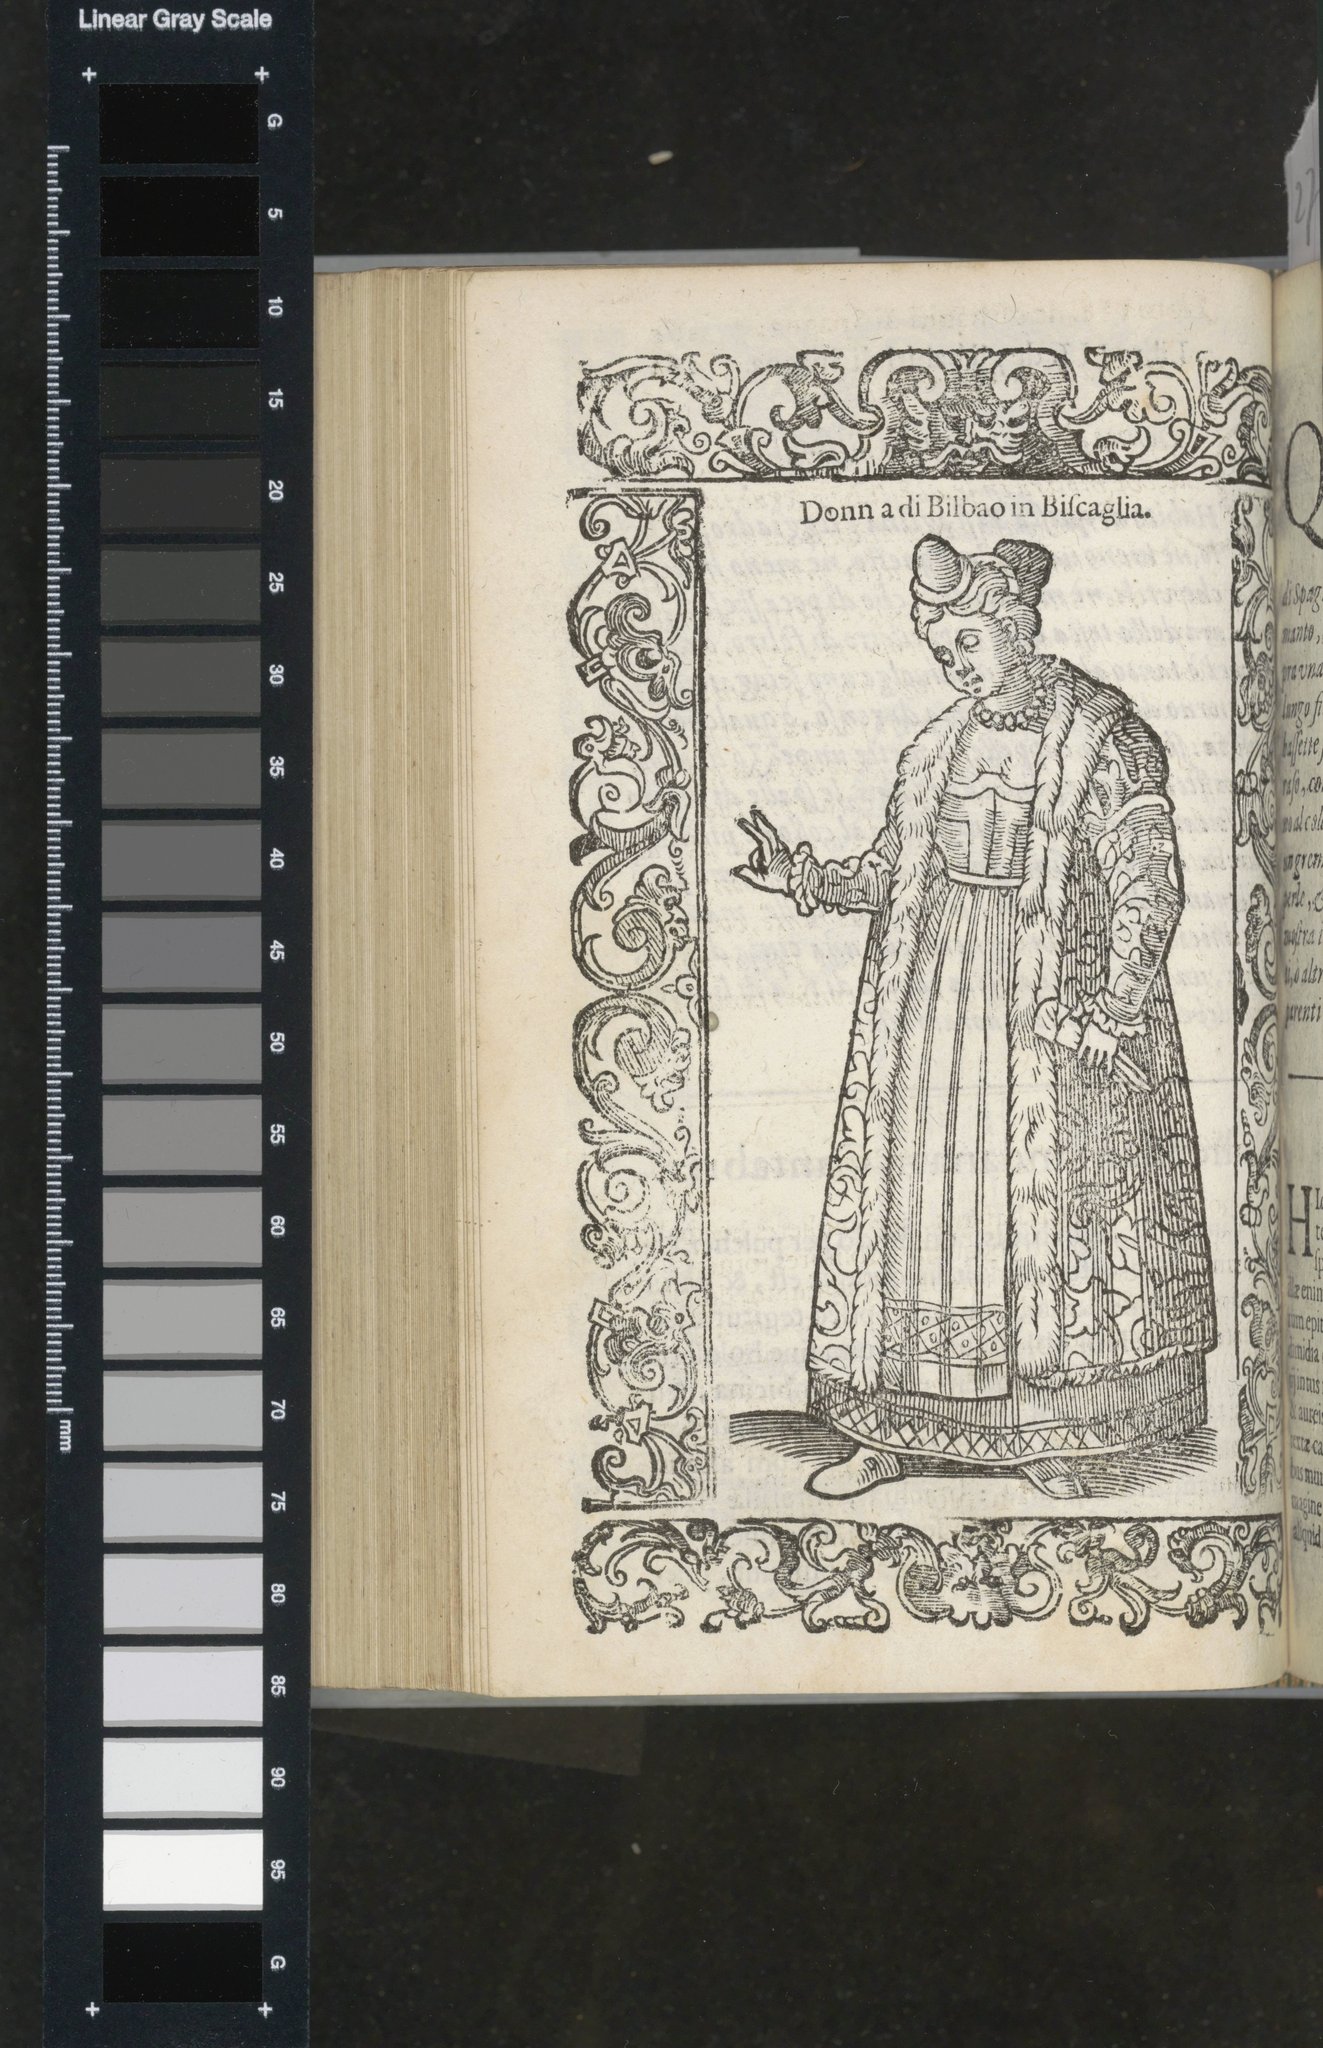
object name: costume print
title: Vrouw uit Bilbao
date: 1598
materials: paper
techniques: woodcut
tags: fashion plates, head-gear: hat (+ women's clothes), gloves, mittens, etc. (+ women's clothes), dress, gown (+ women's clothes), pearl; pearl necklace (+ women's clothes)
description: Vrouw uit Bilbao in een 'robba' of overkleed, afgezet met bont. Daaronder een enkellang kleed van satijn met banden van brokaat. Parelsnoer om de hals. Heel klein hoedje op het voorhoofd (door Vecellio bizar genoemd) Handschoenen in de hand. In ornamentrand.